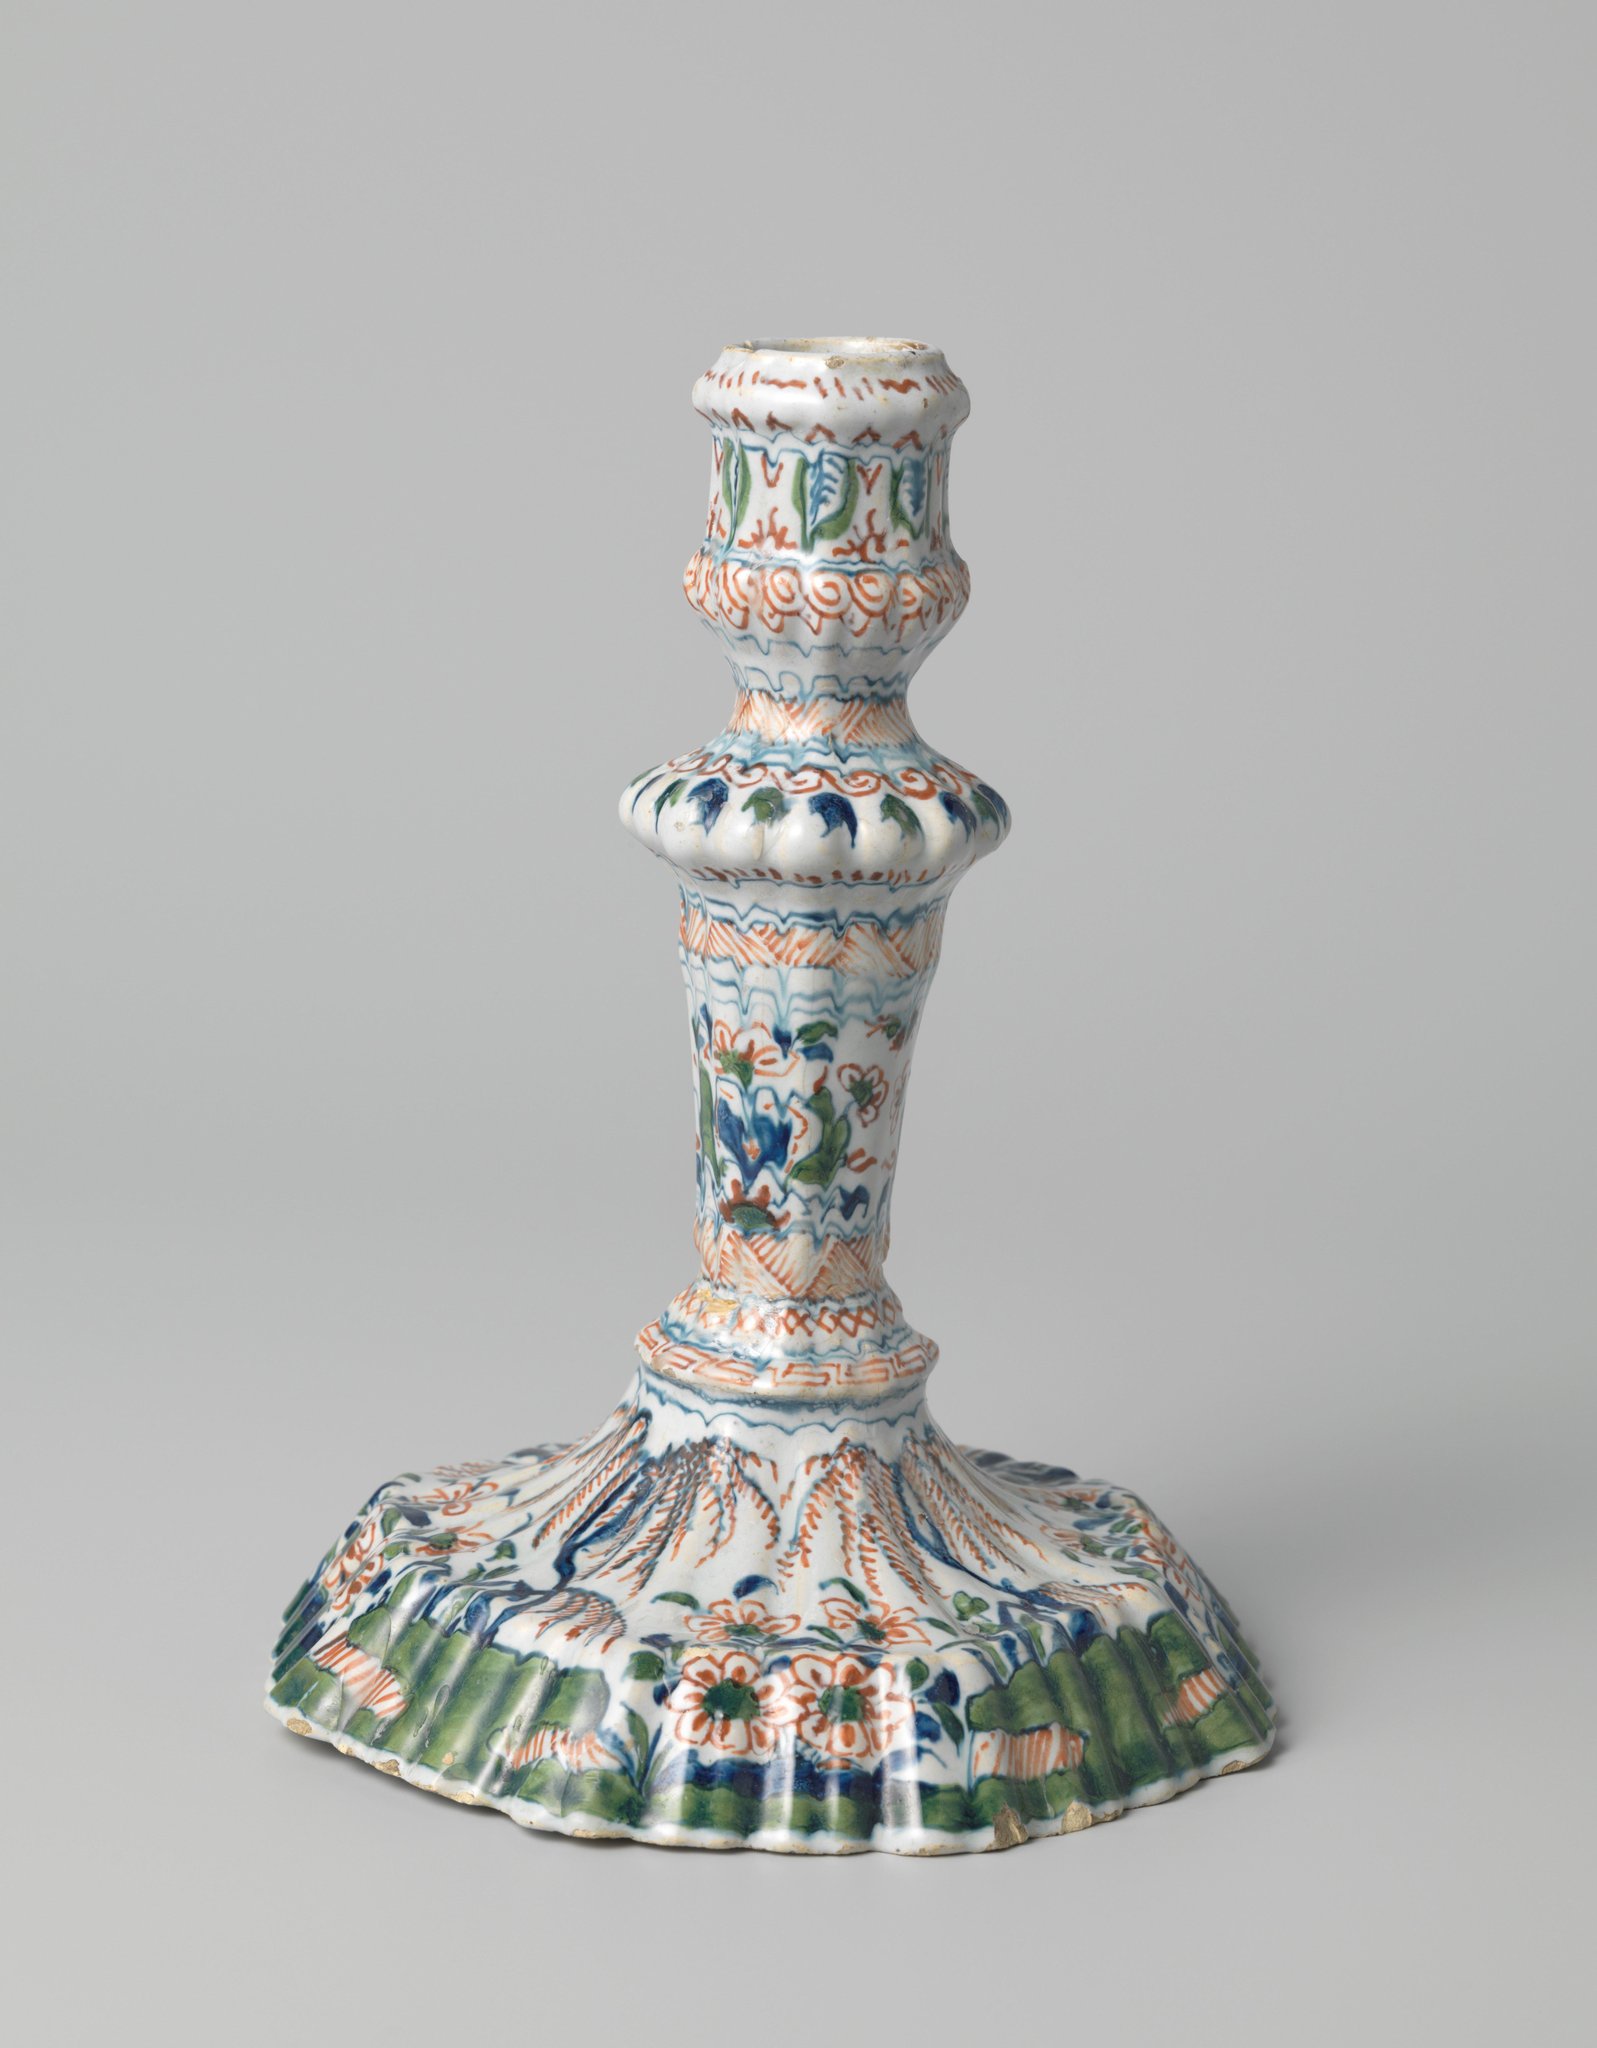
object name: candlestick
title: Kandelaar met veelkleurige beschildering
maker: Anonymous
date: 1690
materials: faience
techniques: painted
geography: delft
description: Kandelaar van faïence, veelkleurig beschilderd onder het glazuur. Achtzijdige voet, gecanneleerde stam. Ongemerkt.